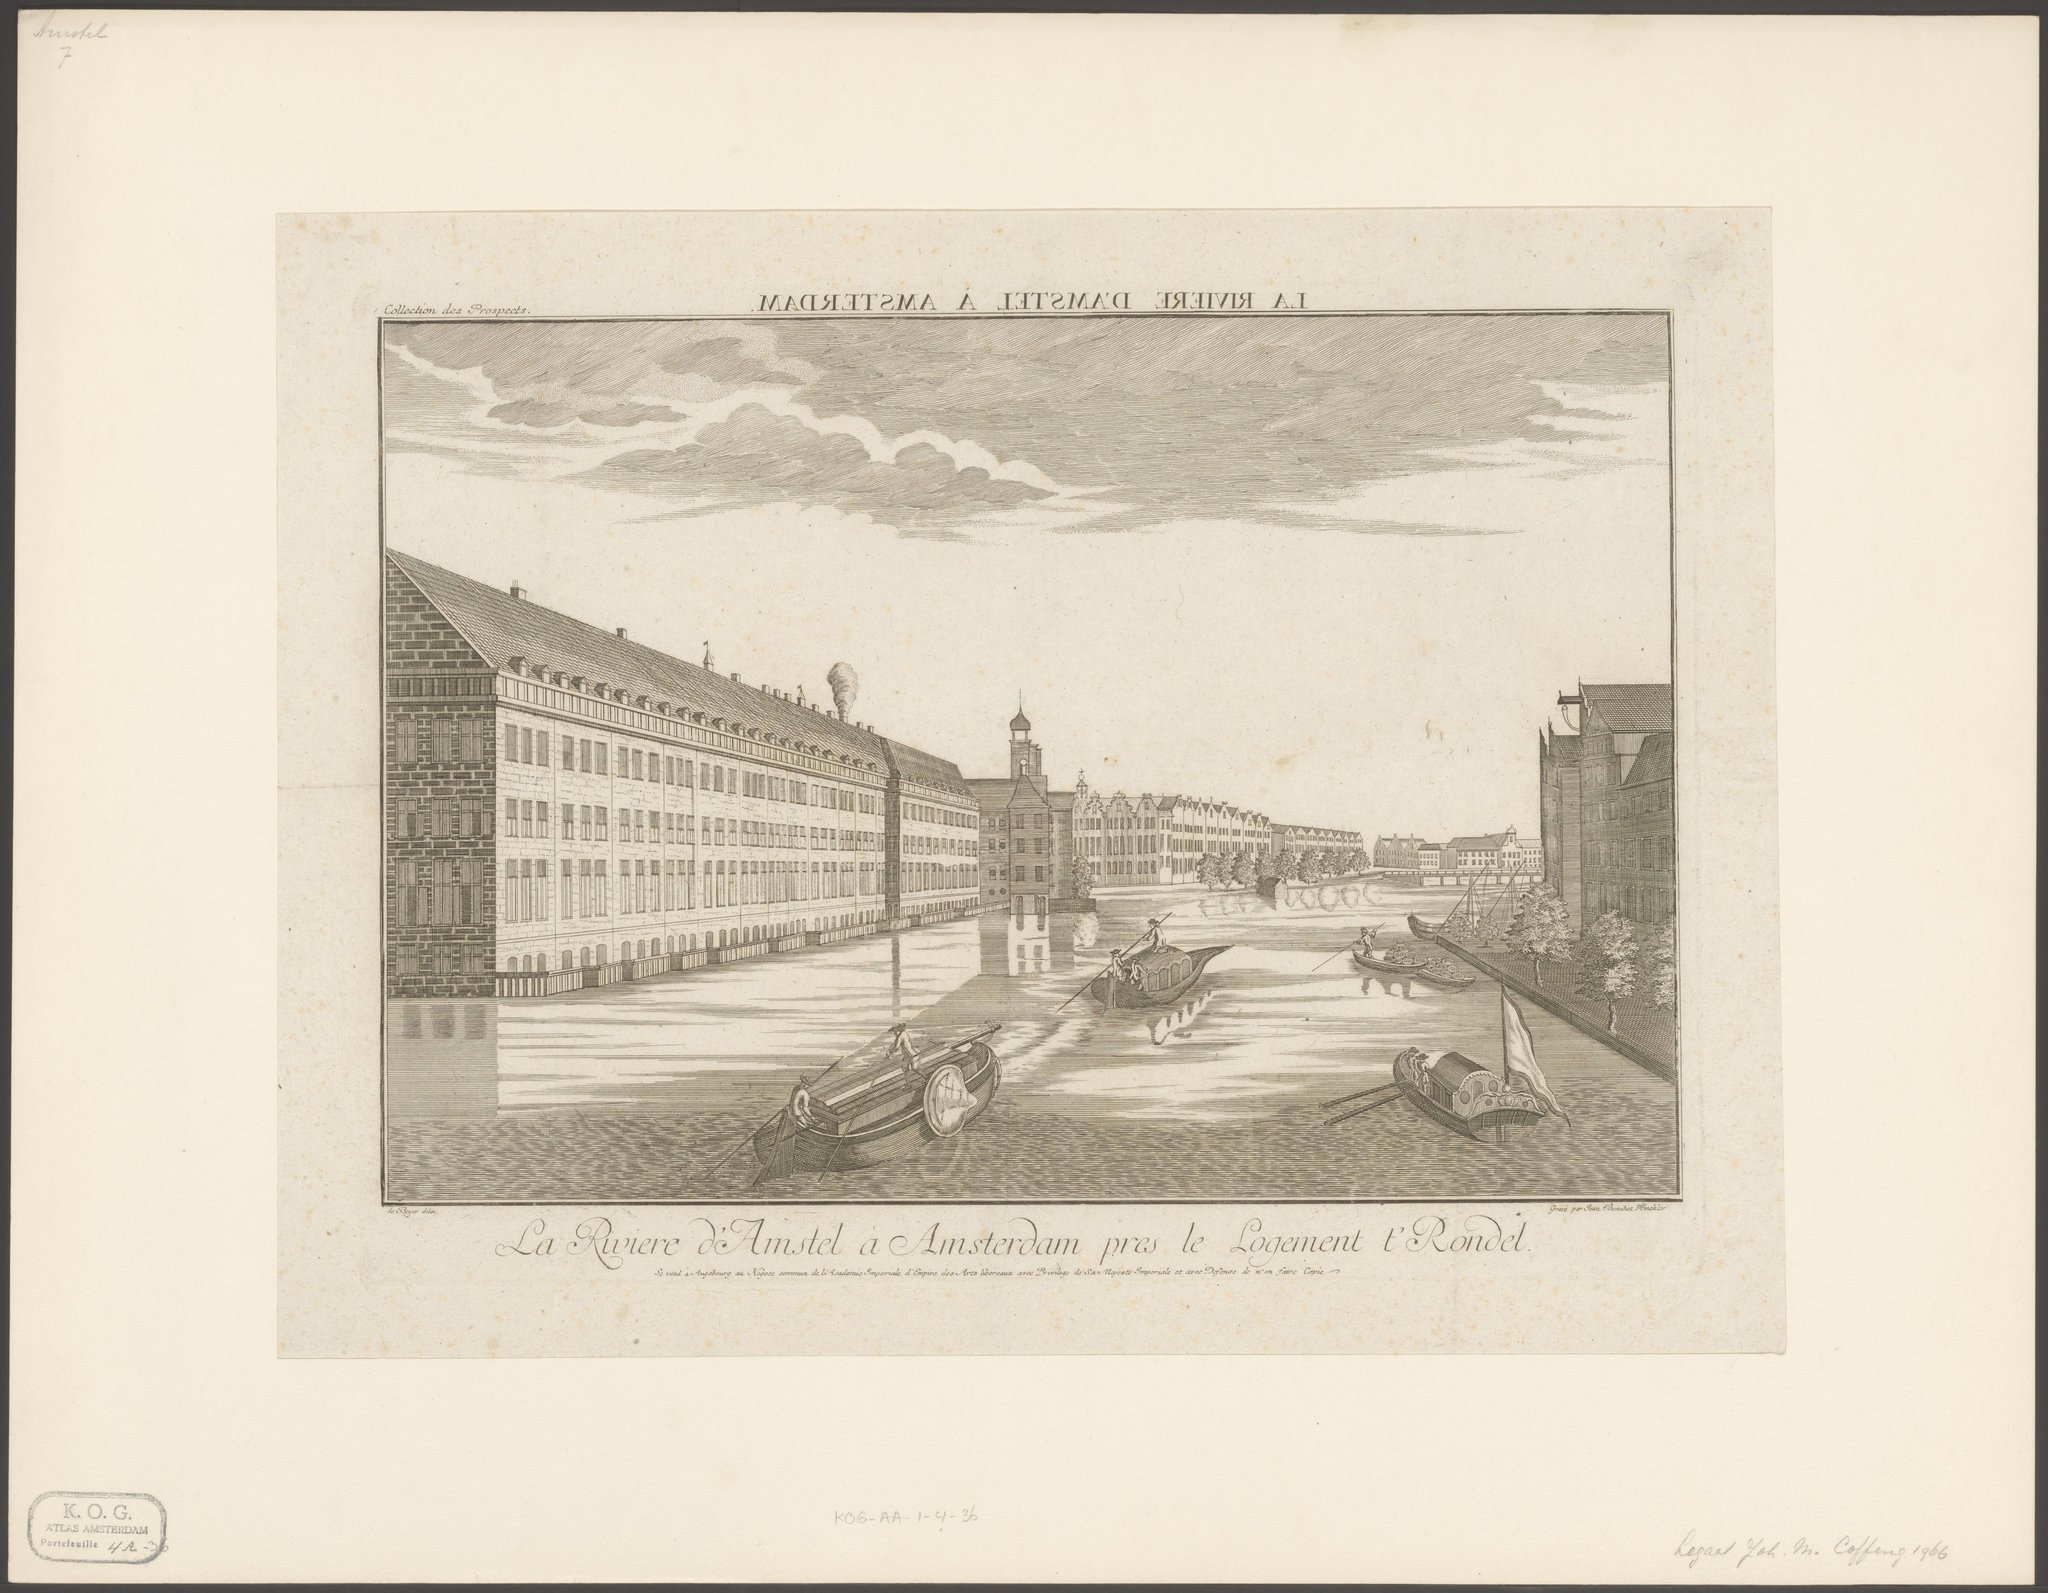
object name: print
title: La Riviere d'Amstel a Amsterdam pres le Logement t' Rondel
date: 1755-1779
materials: paper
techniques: engraving, etching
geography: augsburg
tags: city-view in general; 'veduta', canal, bridge in city across river, canal, etc., boat propelled by man or animal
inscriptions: inscription: ‘Legaat Joh. M. Coffeng. 1966’, collector's mark: ‘4A-36’ Lugt 1641b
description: Onderwerpsrubriek binnen de Atlas Amsterdam: Amstel van Doelensluis tot Blauwbrug.